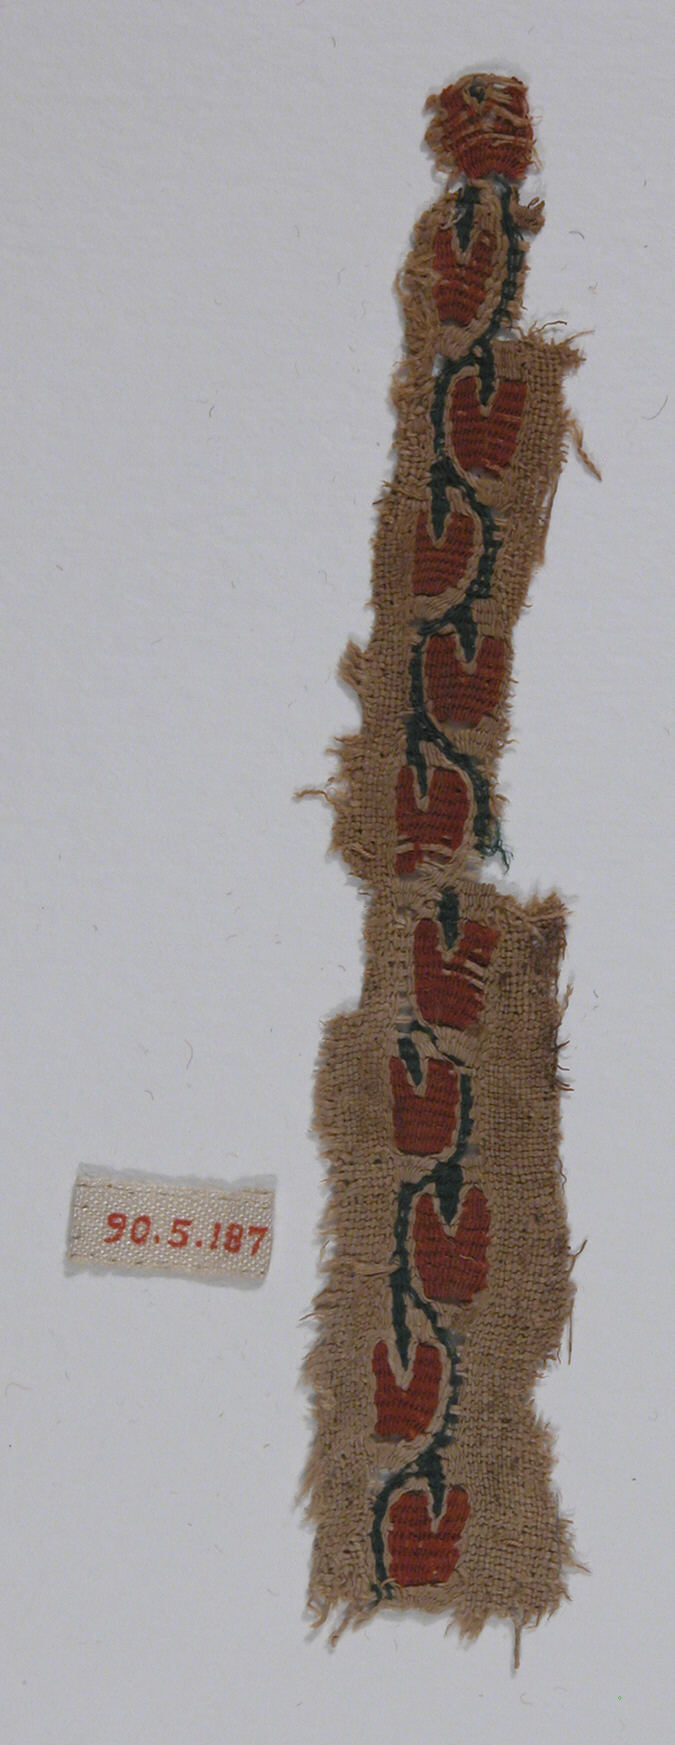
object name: textile fragment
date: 401-500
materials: linen, wool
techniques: weave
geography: egypt